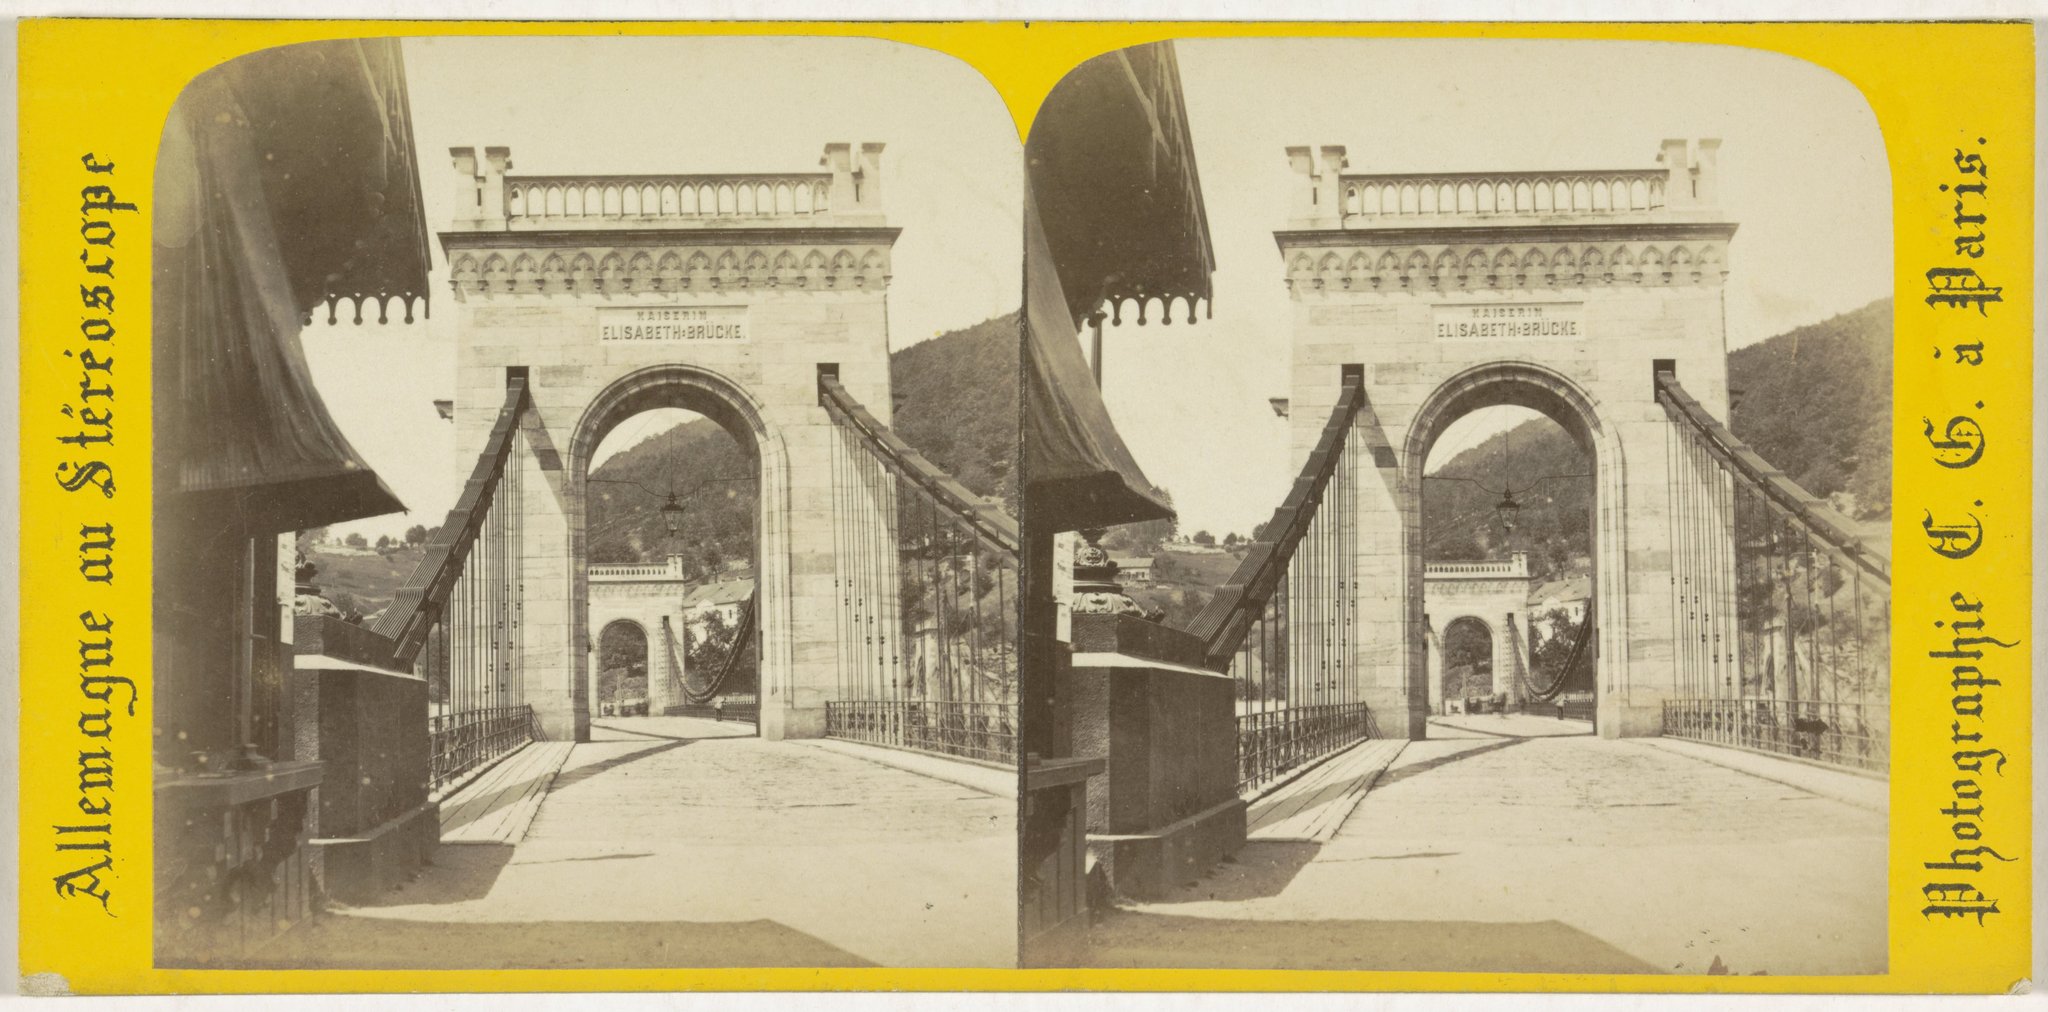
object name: stereograph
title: Bodenbach-Tetschen (Bohême)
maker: charles gaudin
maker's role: publisher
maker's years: 1825-1905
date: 1868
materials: cardboard, paper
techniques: albumen print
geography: decín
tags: suspension bridge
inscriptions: number: ‘208’